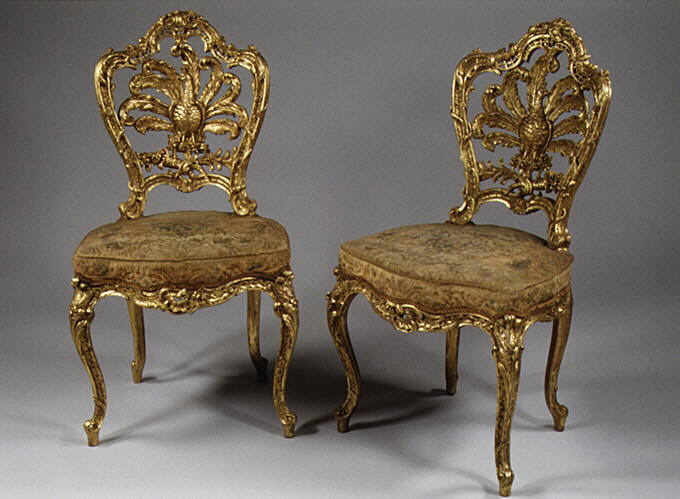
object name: side chair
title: Side chair (one of a pair)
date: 1834-1866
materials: gilt, wood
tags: birds